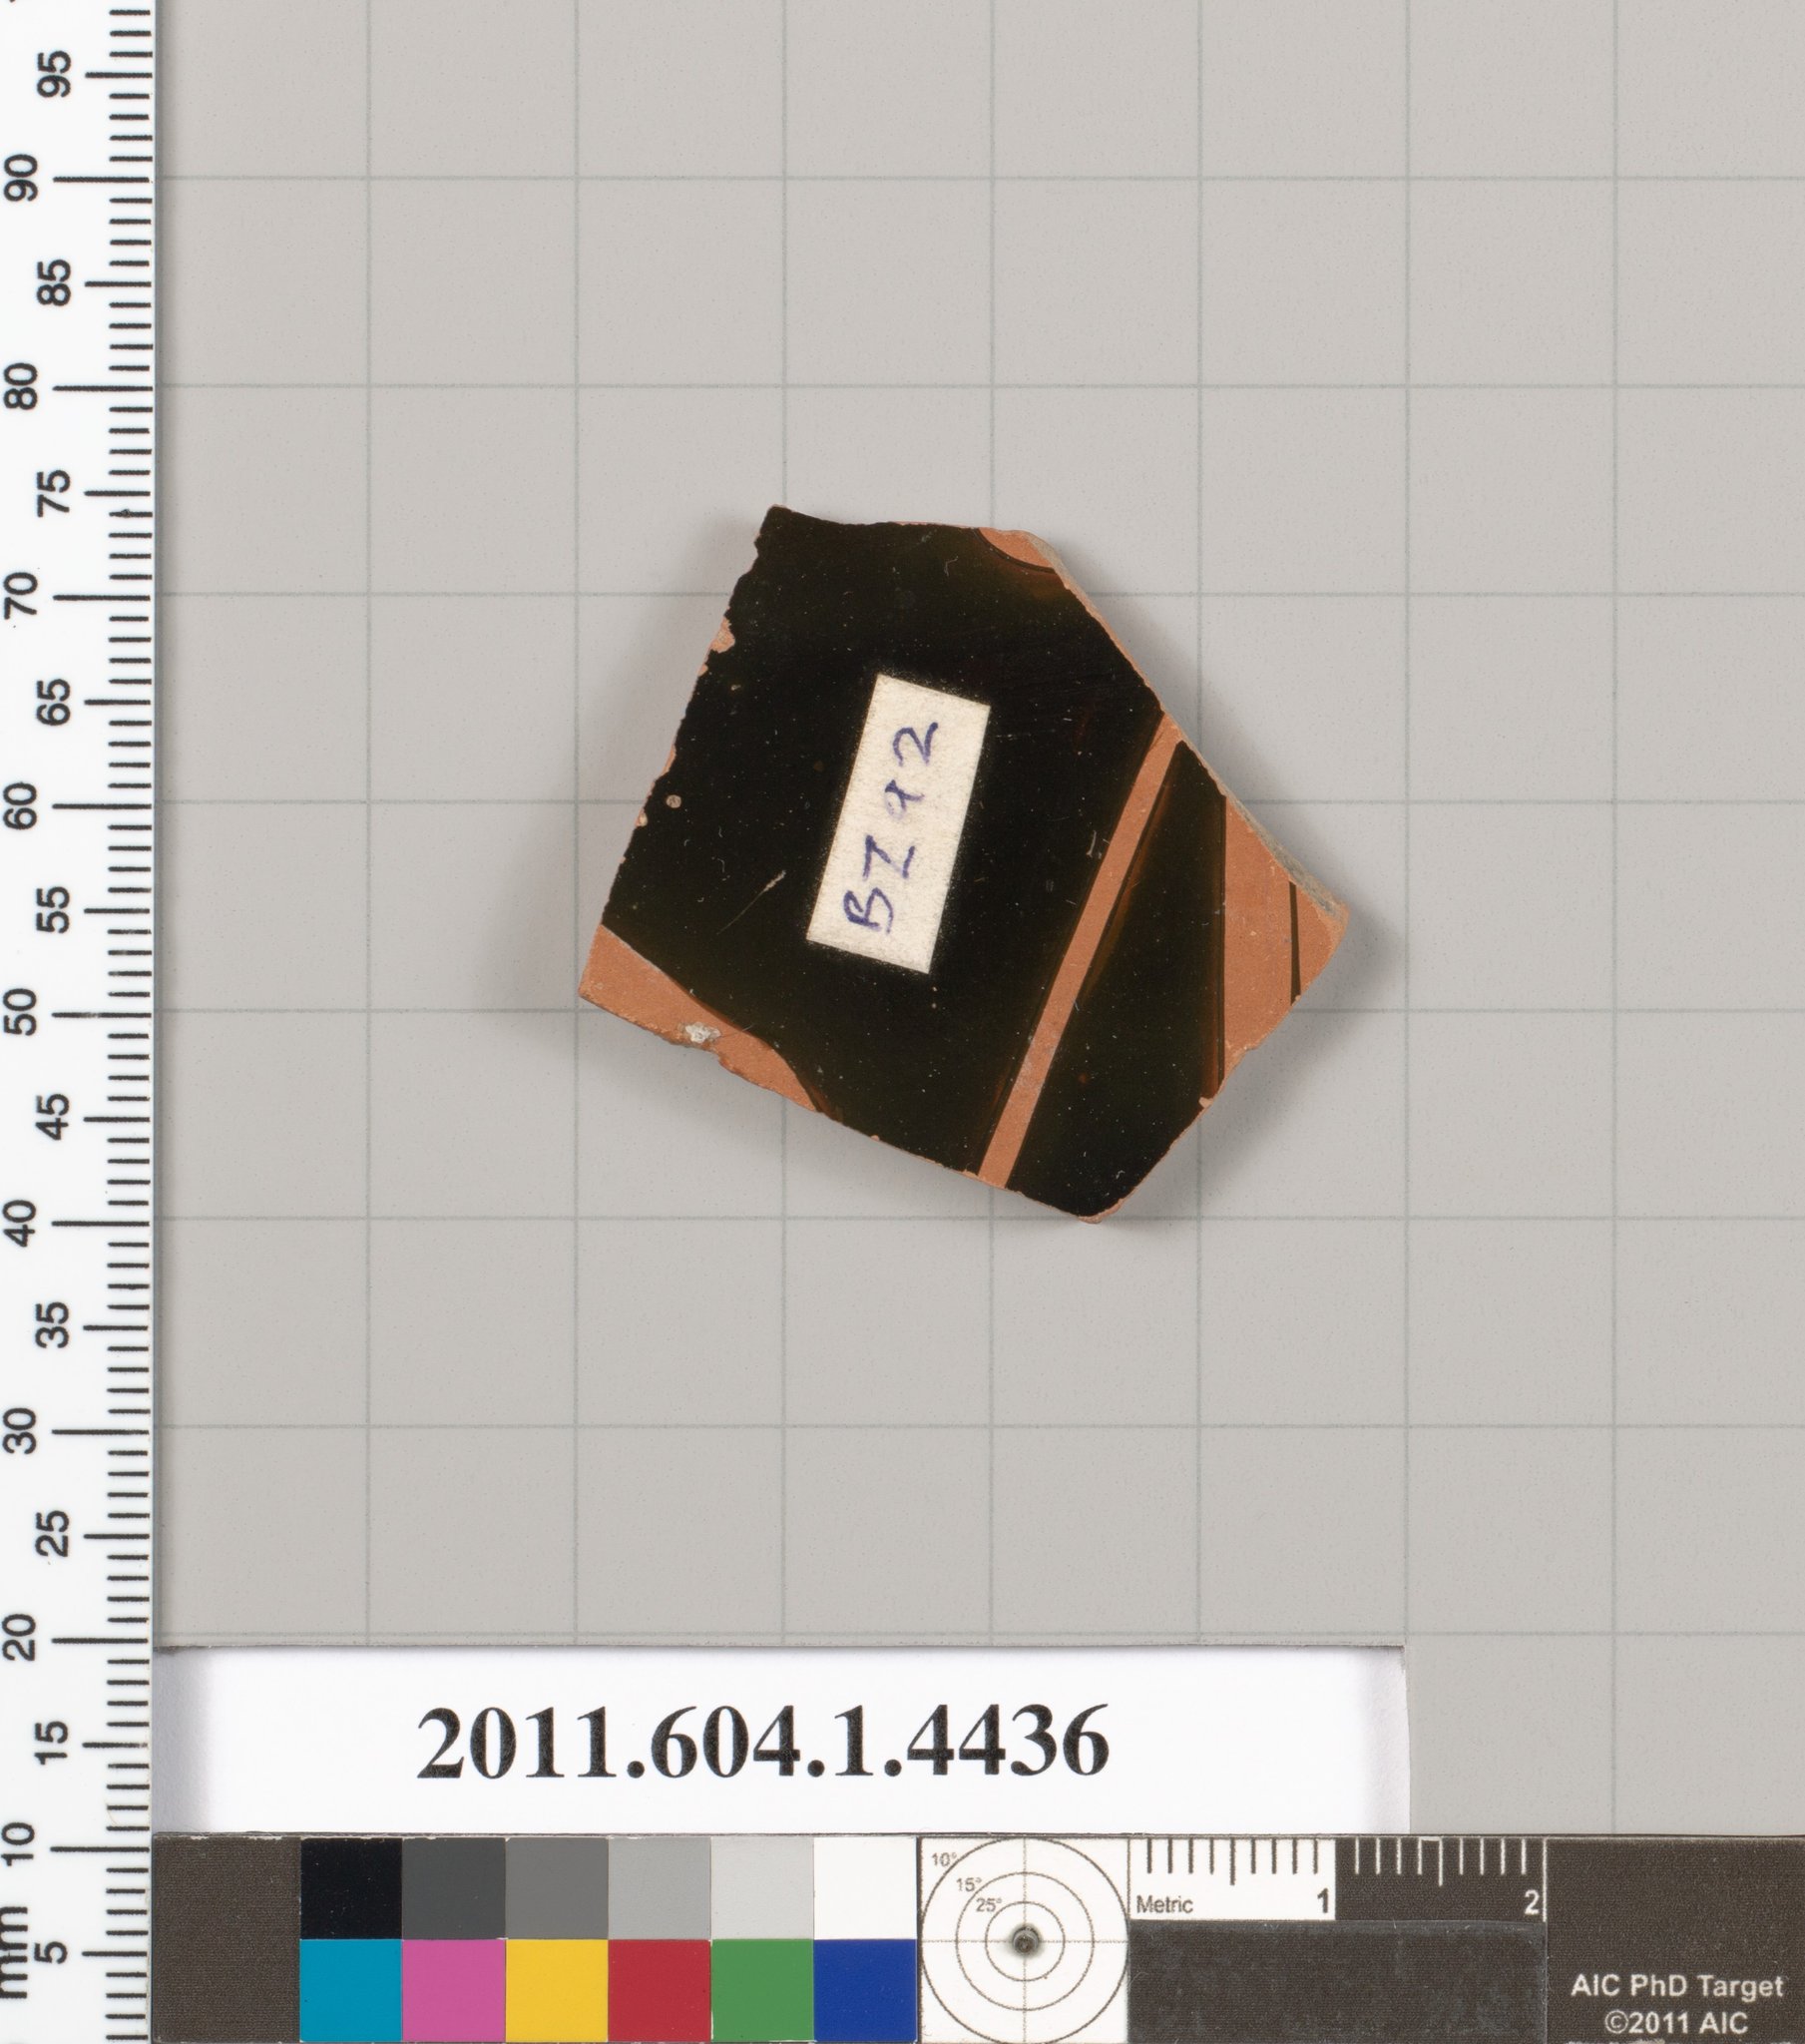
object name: kylix fragment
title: Terracotta fragment of a kylix (drinking cup)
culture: greek, attic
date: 490-480 BCE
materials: terracotta